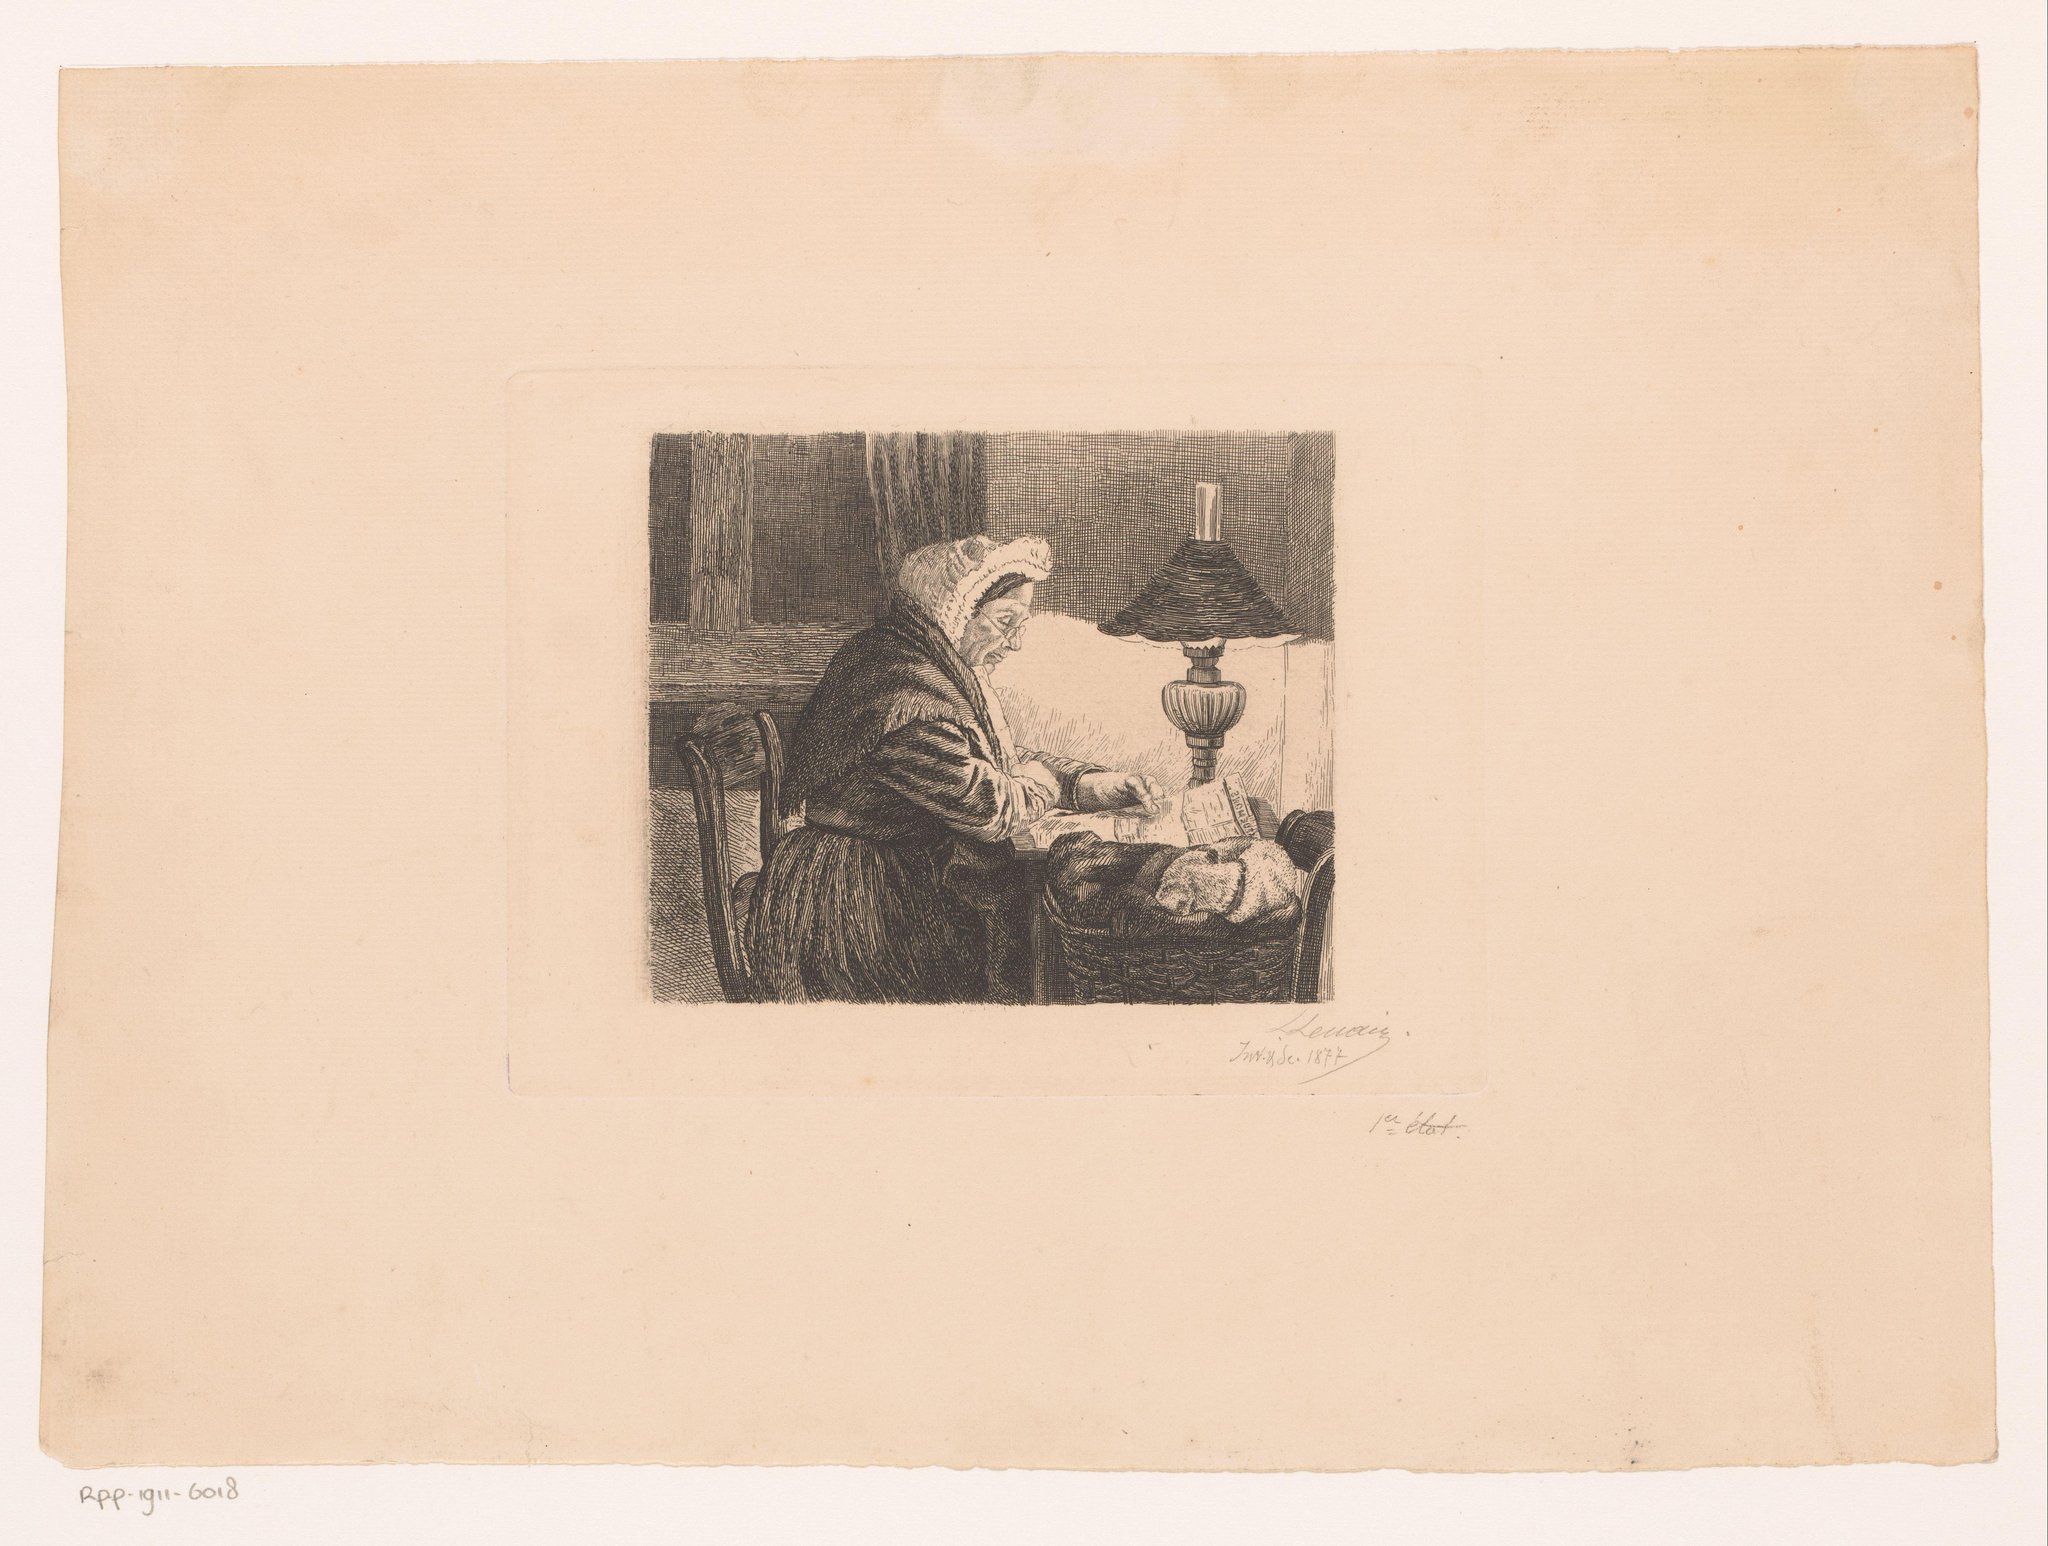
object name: print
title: Oude vrouw leest een krant bij lamplicht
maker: louis le nain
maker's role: print maker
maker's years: 1851-1939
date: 1877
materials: paper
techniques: etching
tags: reading, old woman, lighting; lamps, newspaper, news-sheet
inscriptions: collector's mark: Lugt 2228, inscription: ‘LLeNain inv.&sc. 1877, 1e état’